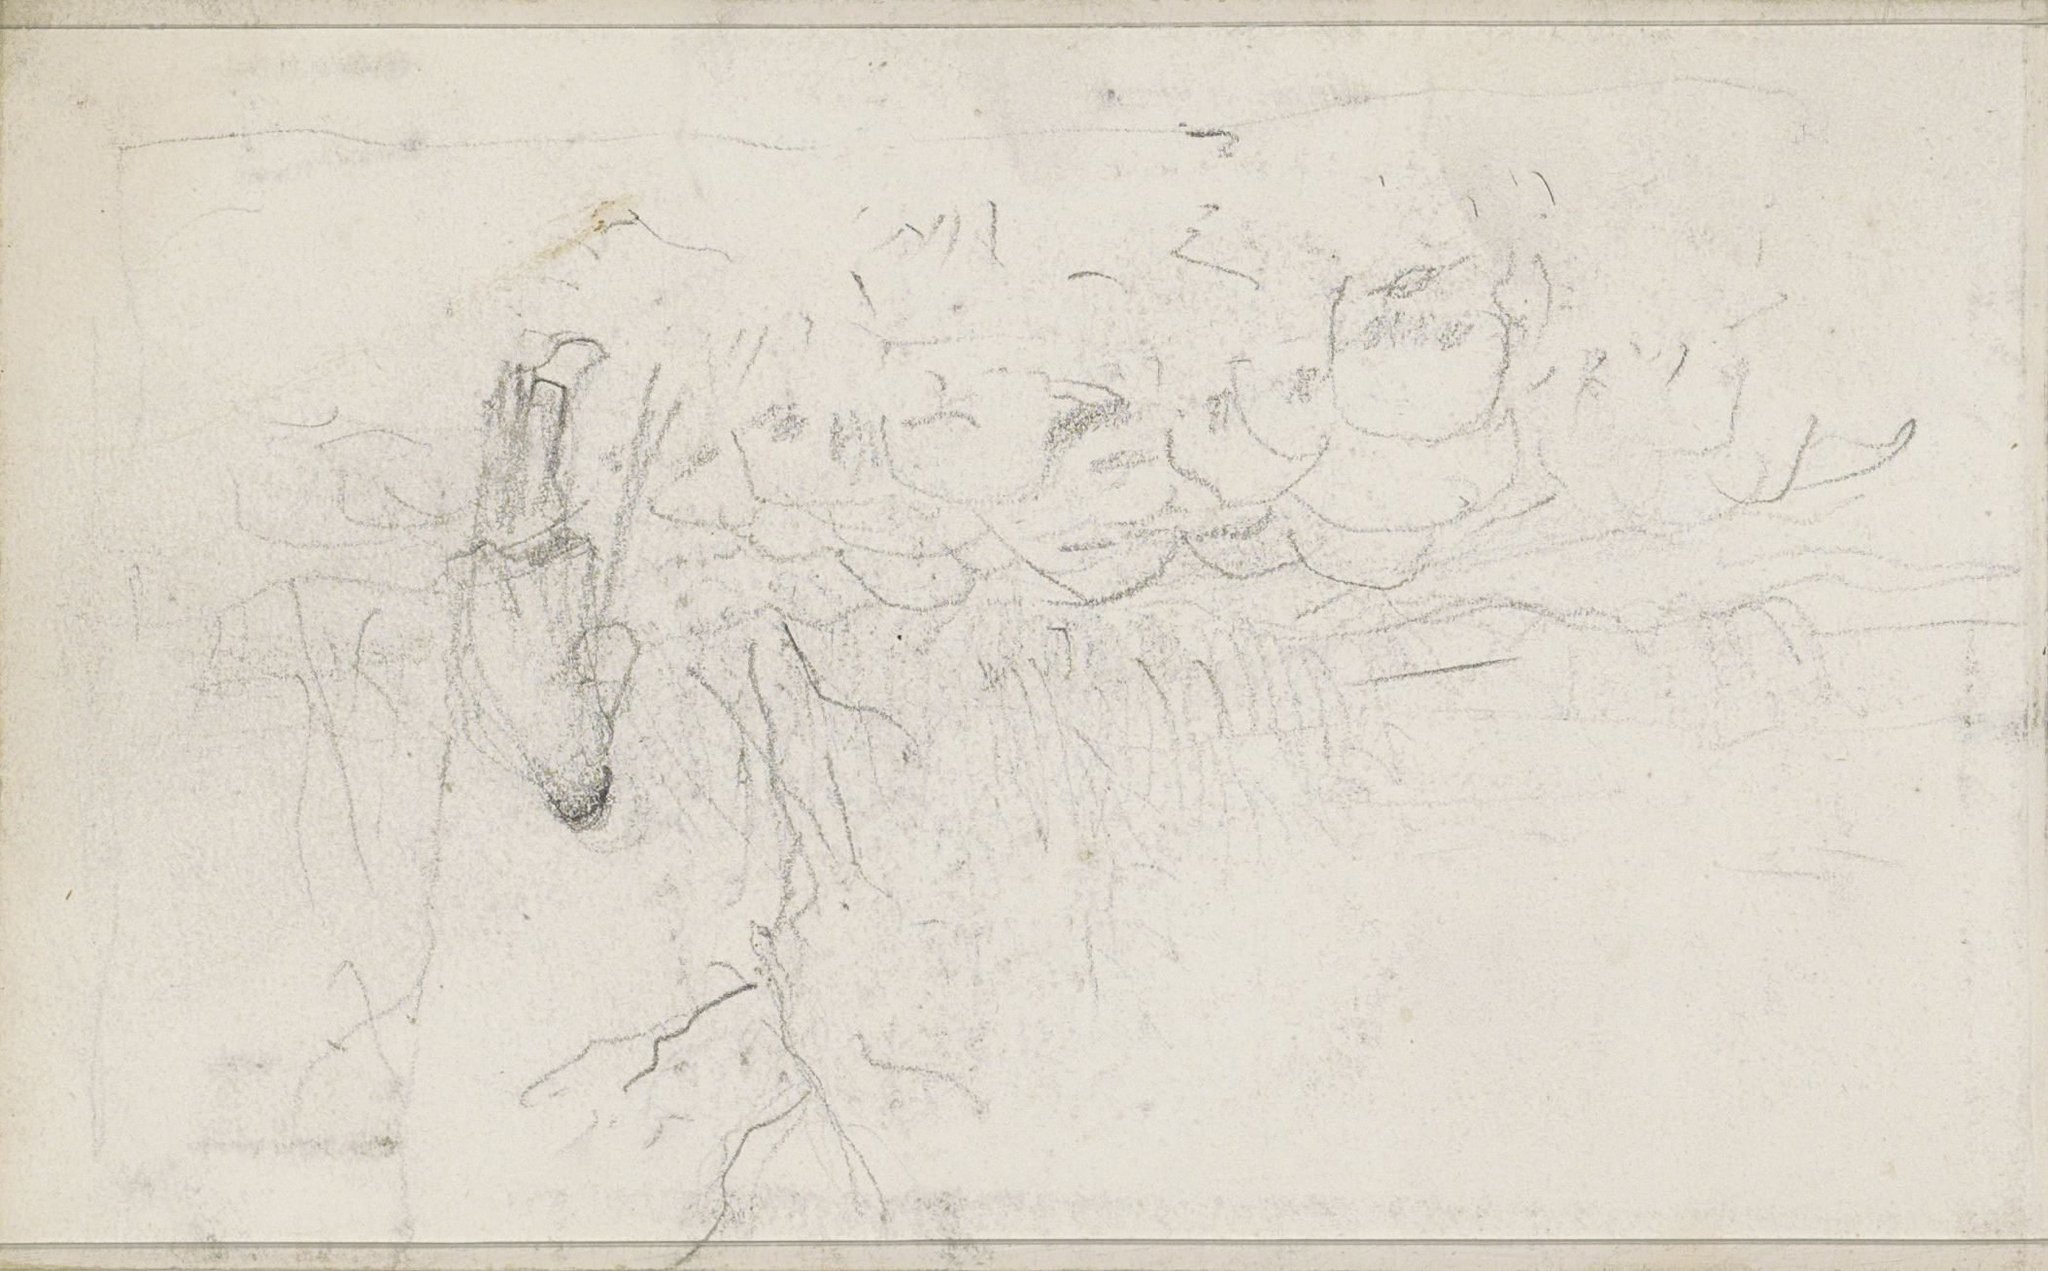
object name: sketchbook leaf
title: Herder met een kudde schapen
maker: anton mauve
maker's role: draughtsman, painter, print maker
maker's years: 1838-1888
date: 1848-1888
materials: paper, pencil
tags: herding, herdsman, herdswoman, shepherd, shepherdess, cowherd, etc., sheep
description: Blad 43 verso uit een schetsboek met 43 bladen.